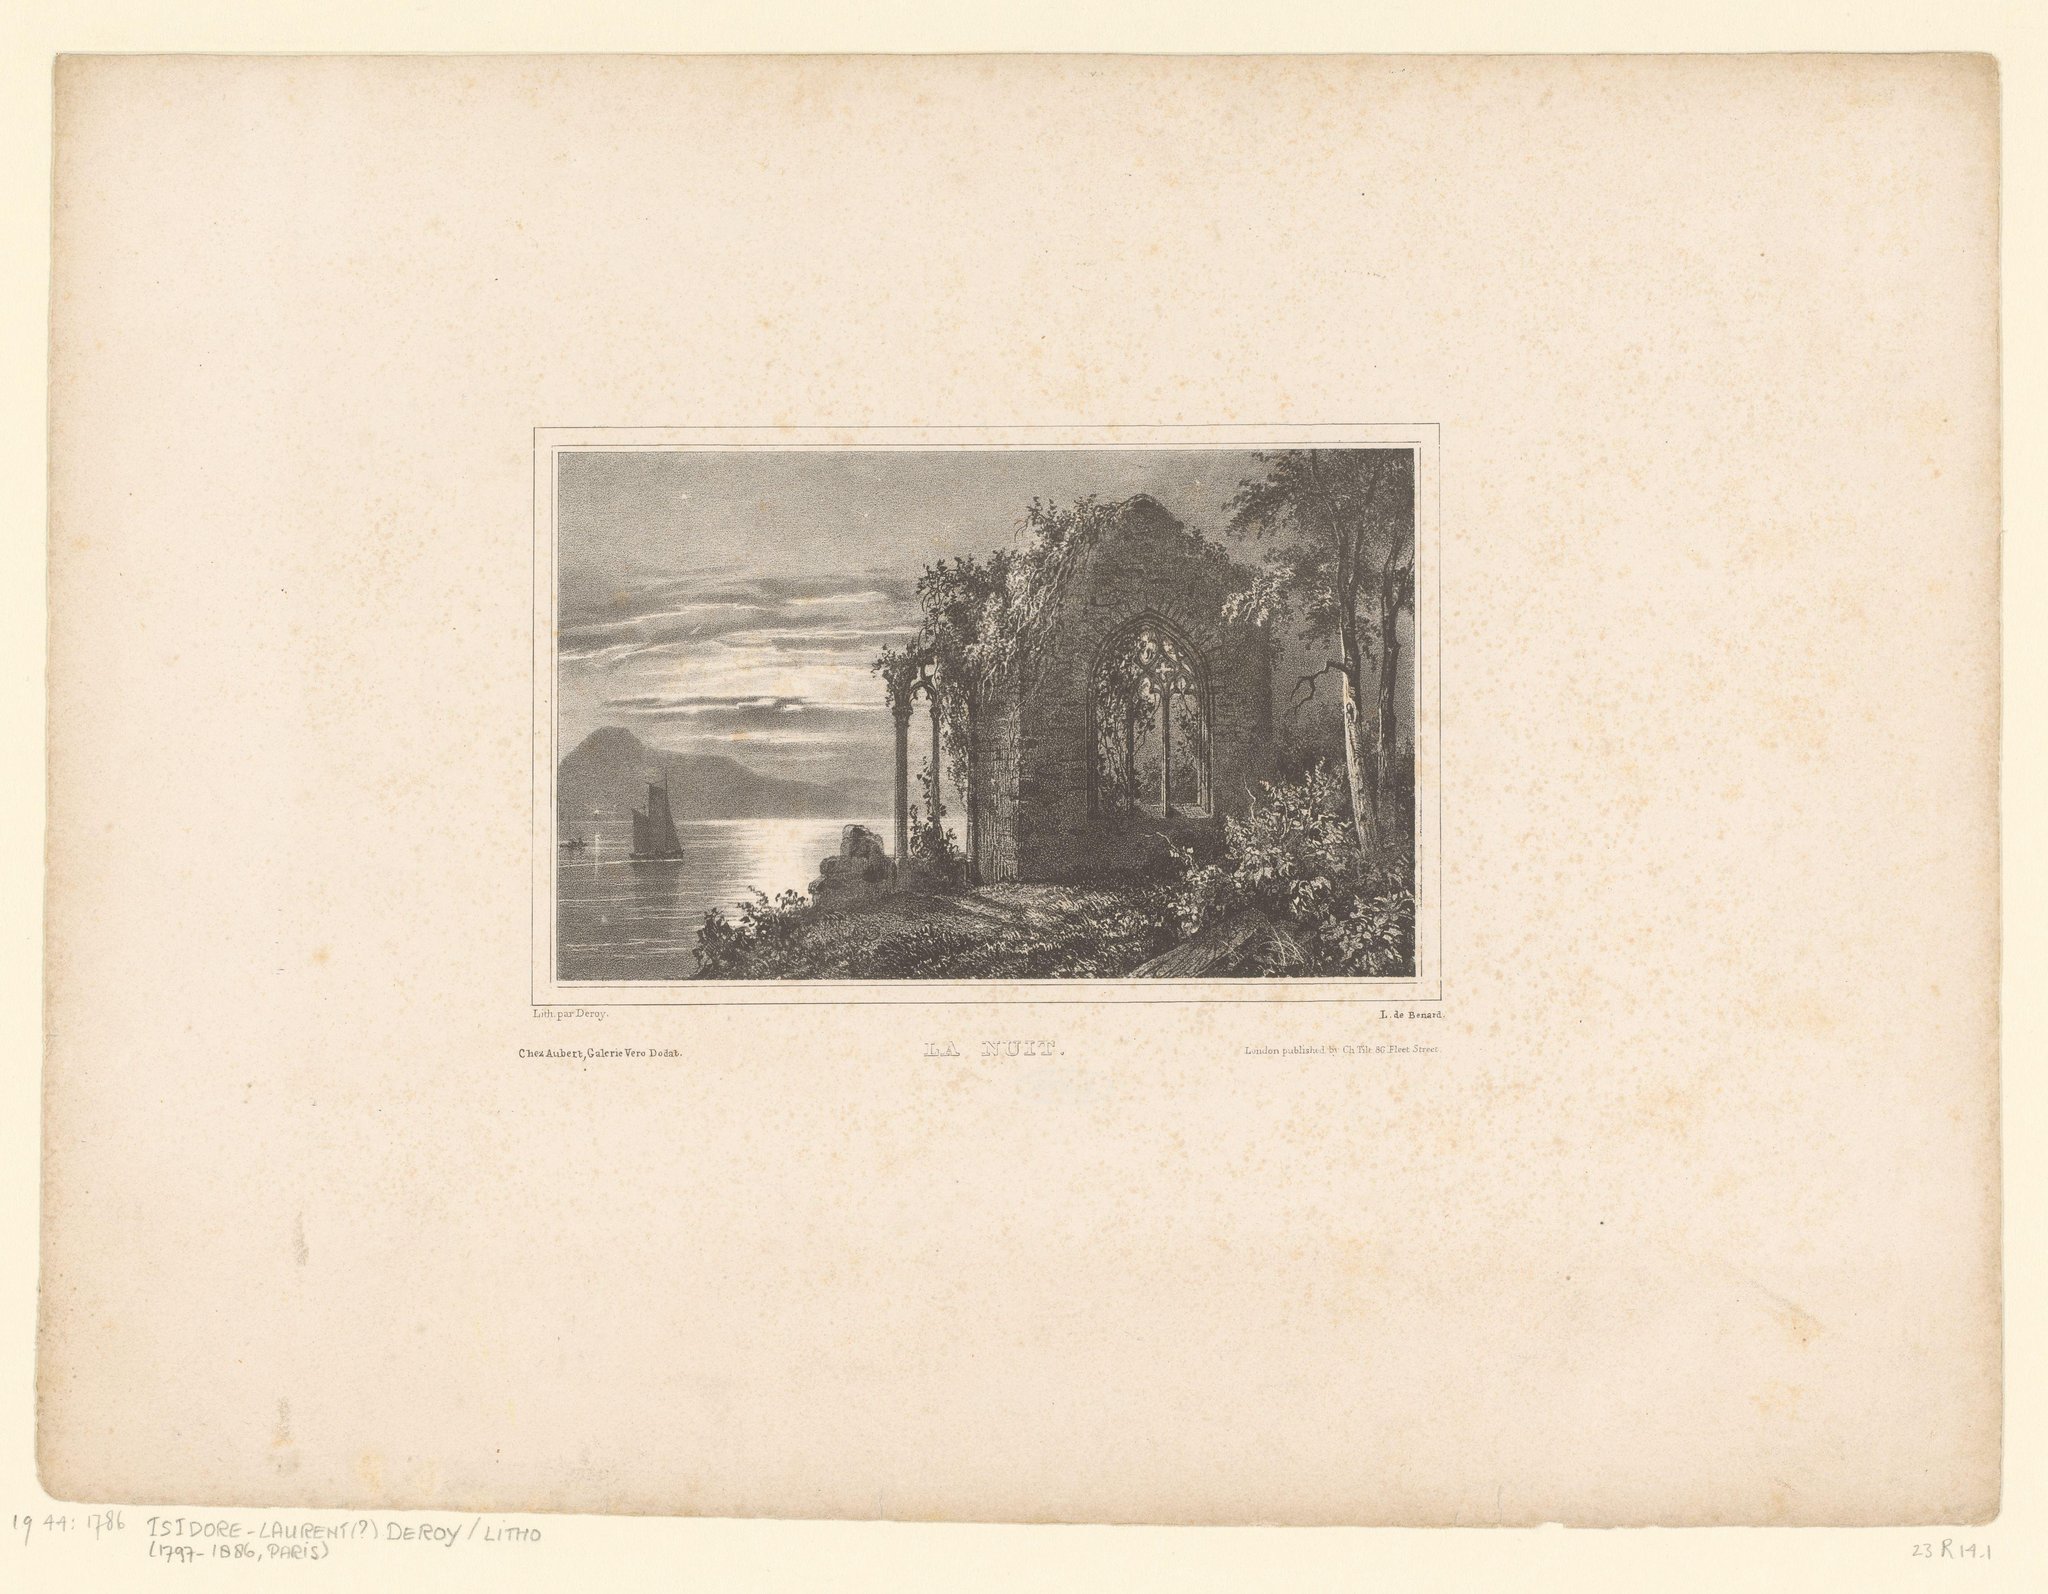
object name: print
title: Dag en nacht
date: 1832-1841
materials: paper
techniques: lithograph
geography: paris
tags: moonlight, ruin of church, monastery, etc., night ~ landscape (sometimes titled 'nox'), lake (+ landscape with figures, staffage)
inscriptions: collector's mark: Lugt 2228